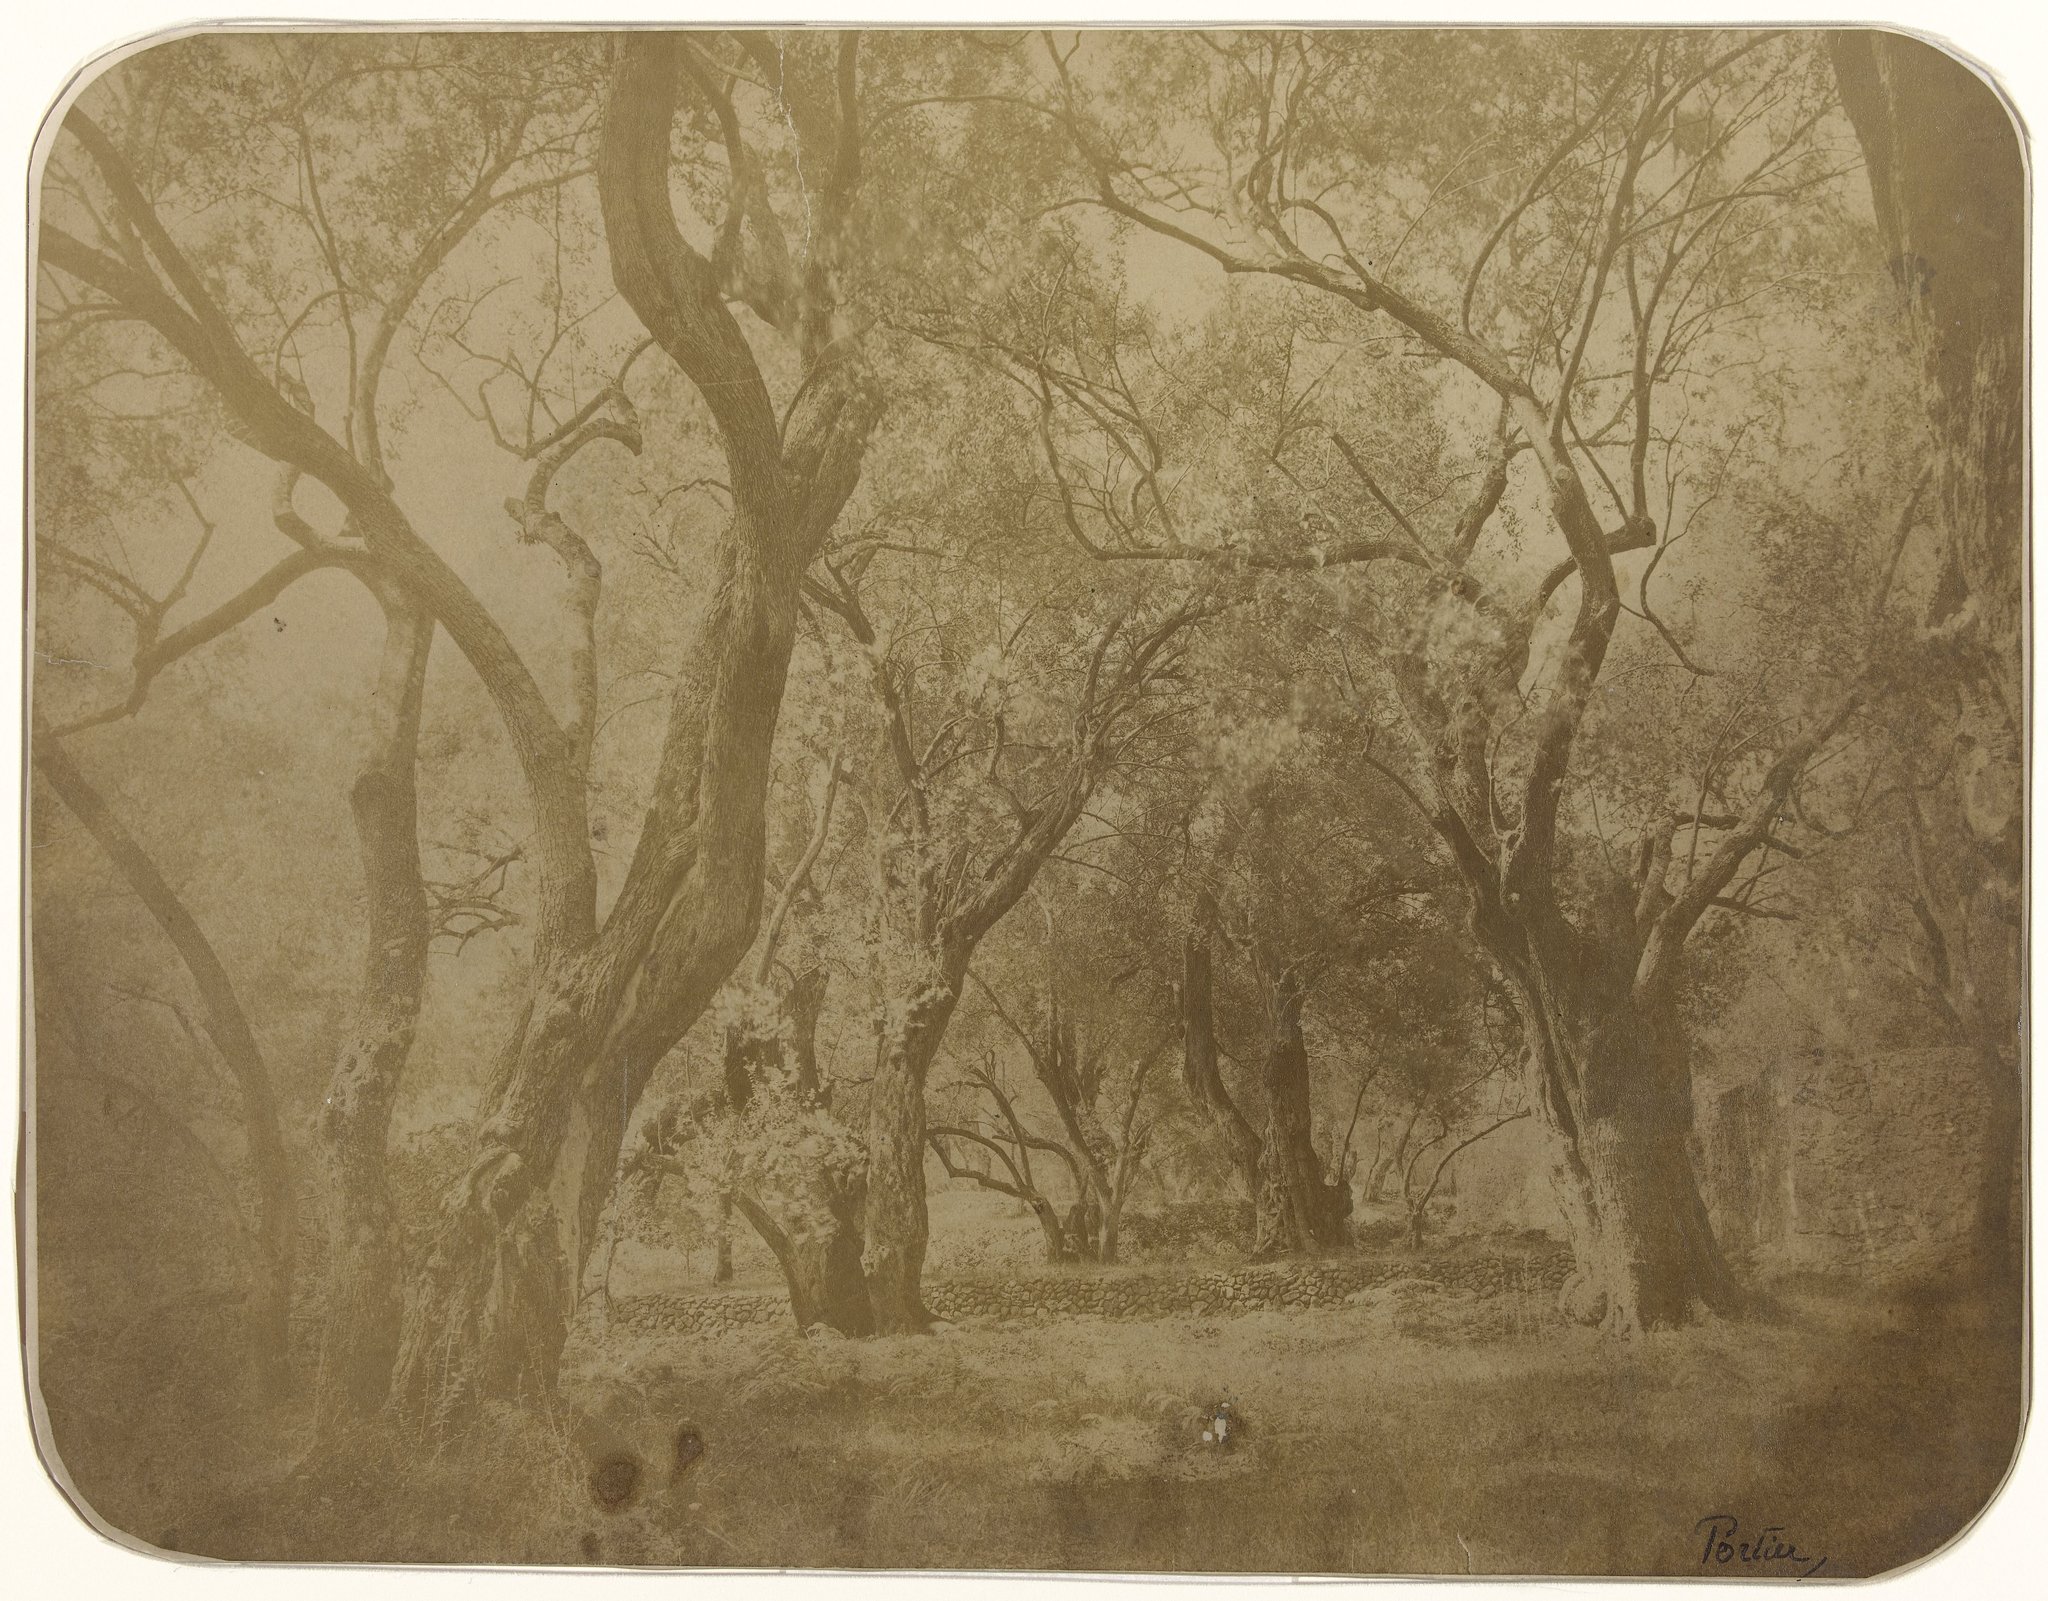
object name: photograph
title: Boslandschap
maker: portier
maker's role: fotograaf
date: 1858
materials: paper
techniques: albumen print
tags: forest, wood, france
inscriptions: inscription: ‘75,-’, number: ‘102’, inscription: ‘Portier: 1858’